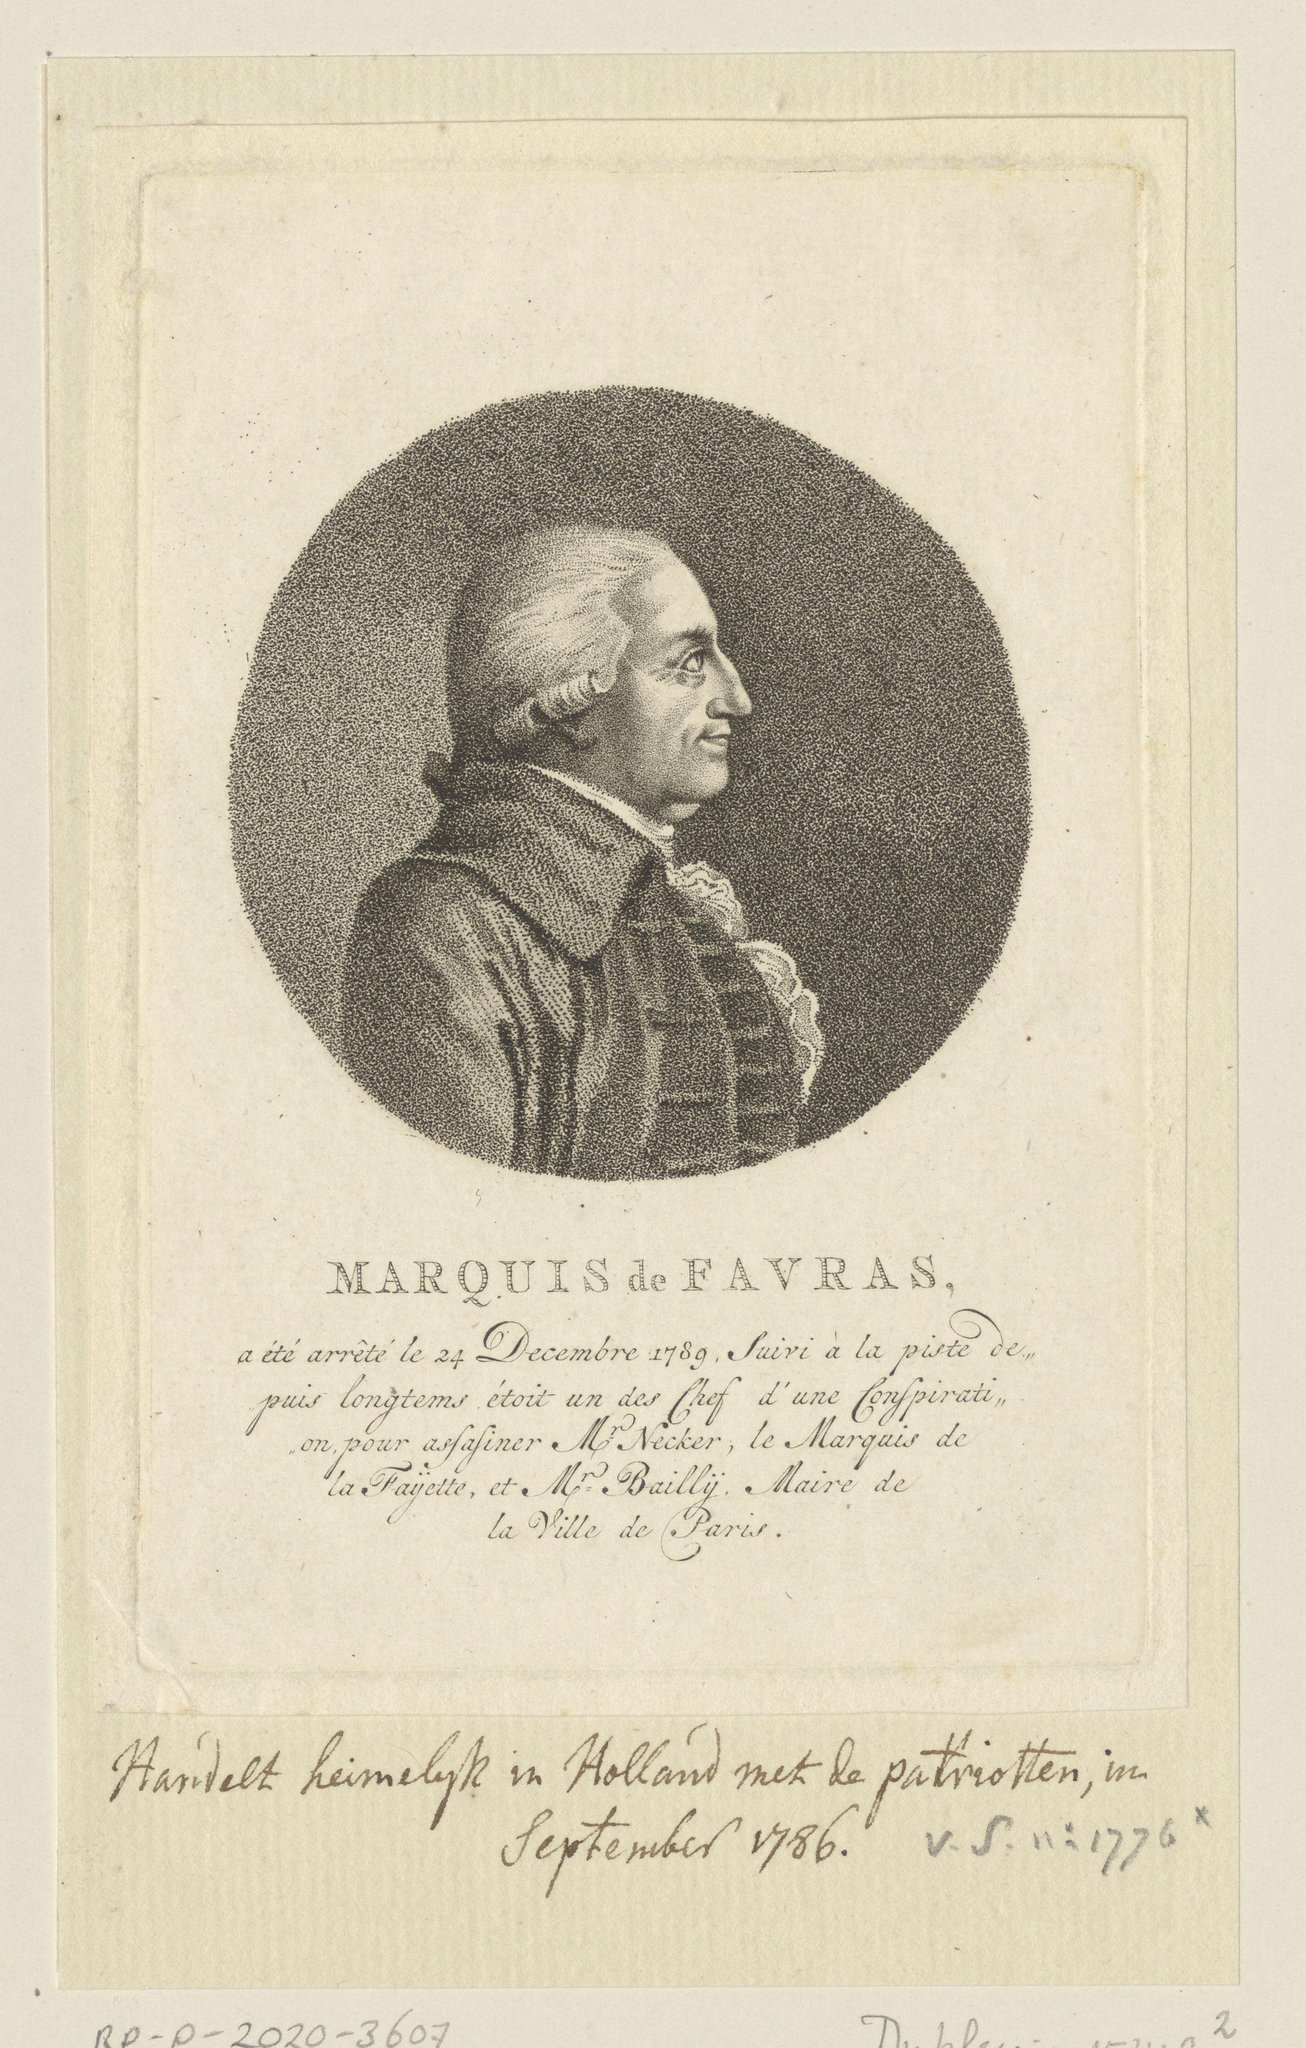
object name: print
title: Portret van Thomas de Mahy, markies van Favras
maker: Anonymous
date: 1789-1800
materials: paper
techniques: stippling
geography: france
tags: historical persons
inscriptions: inscription: ‘Handelt heimelijk in Holland met de patriotten, in/ September 1786’